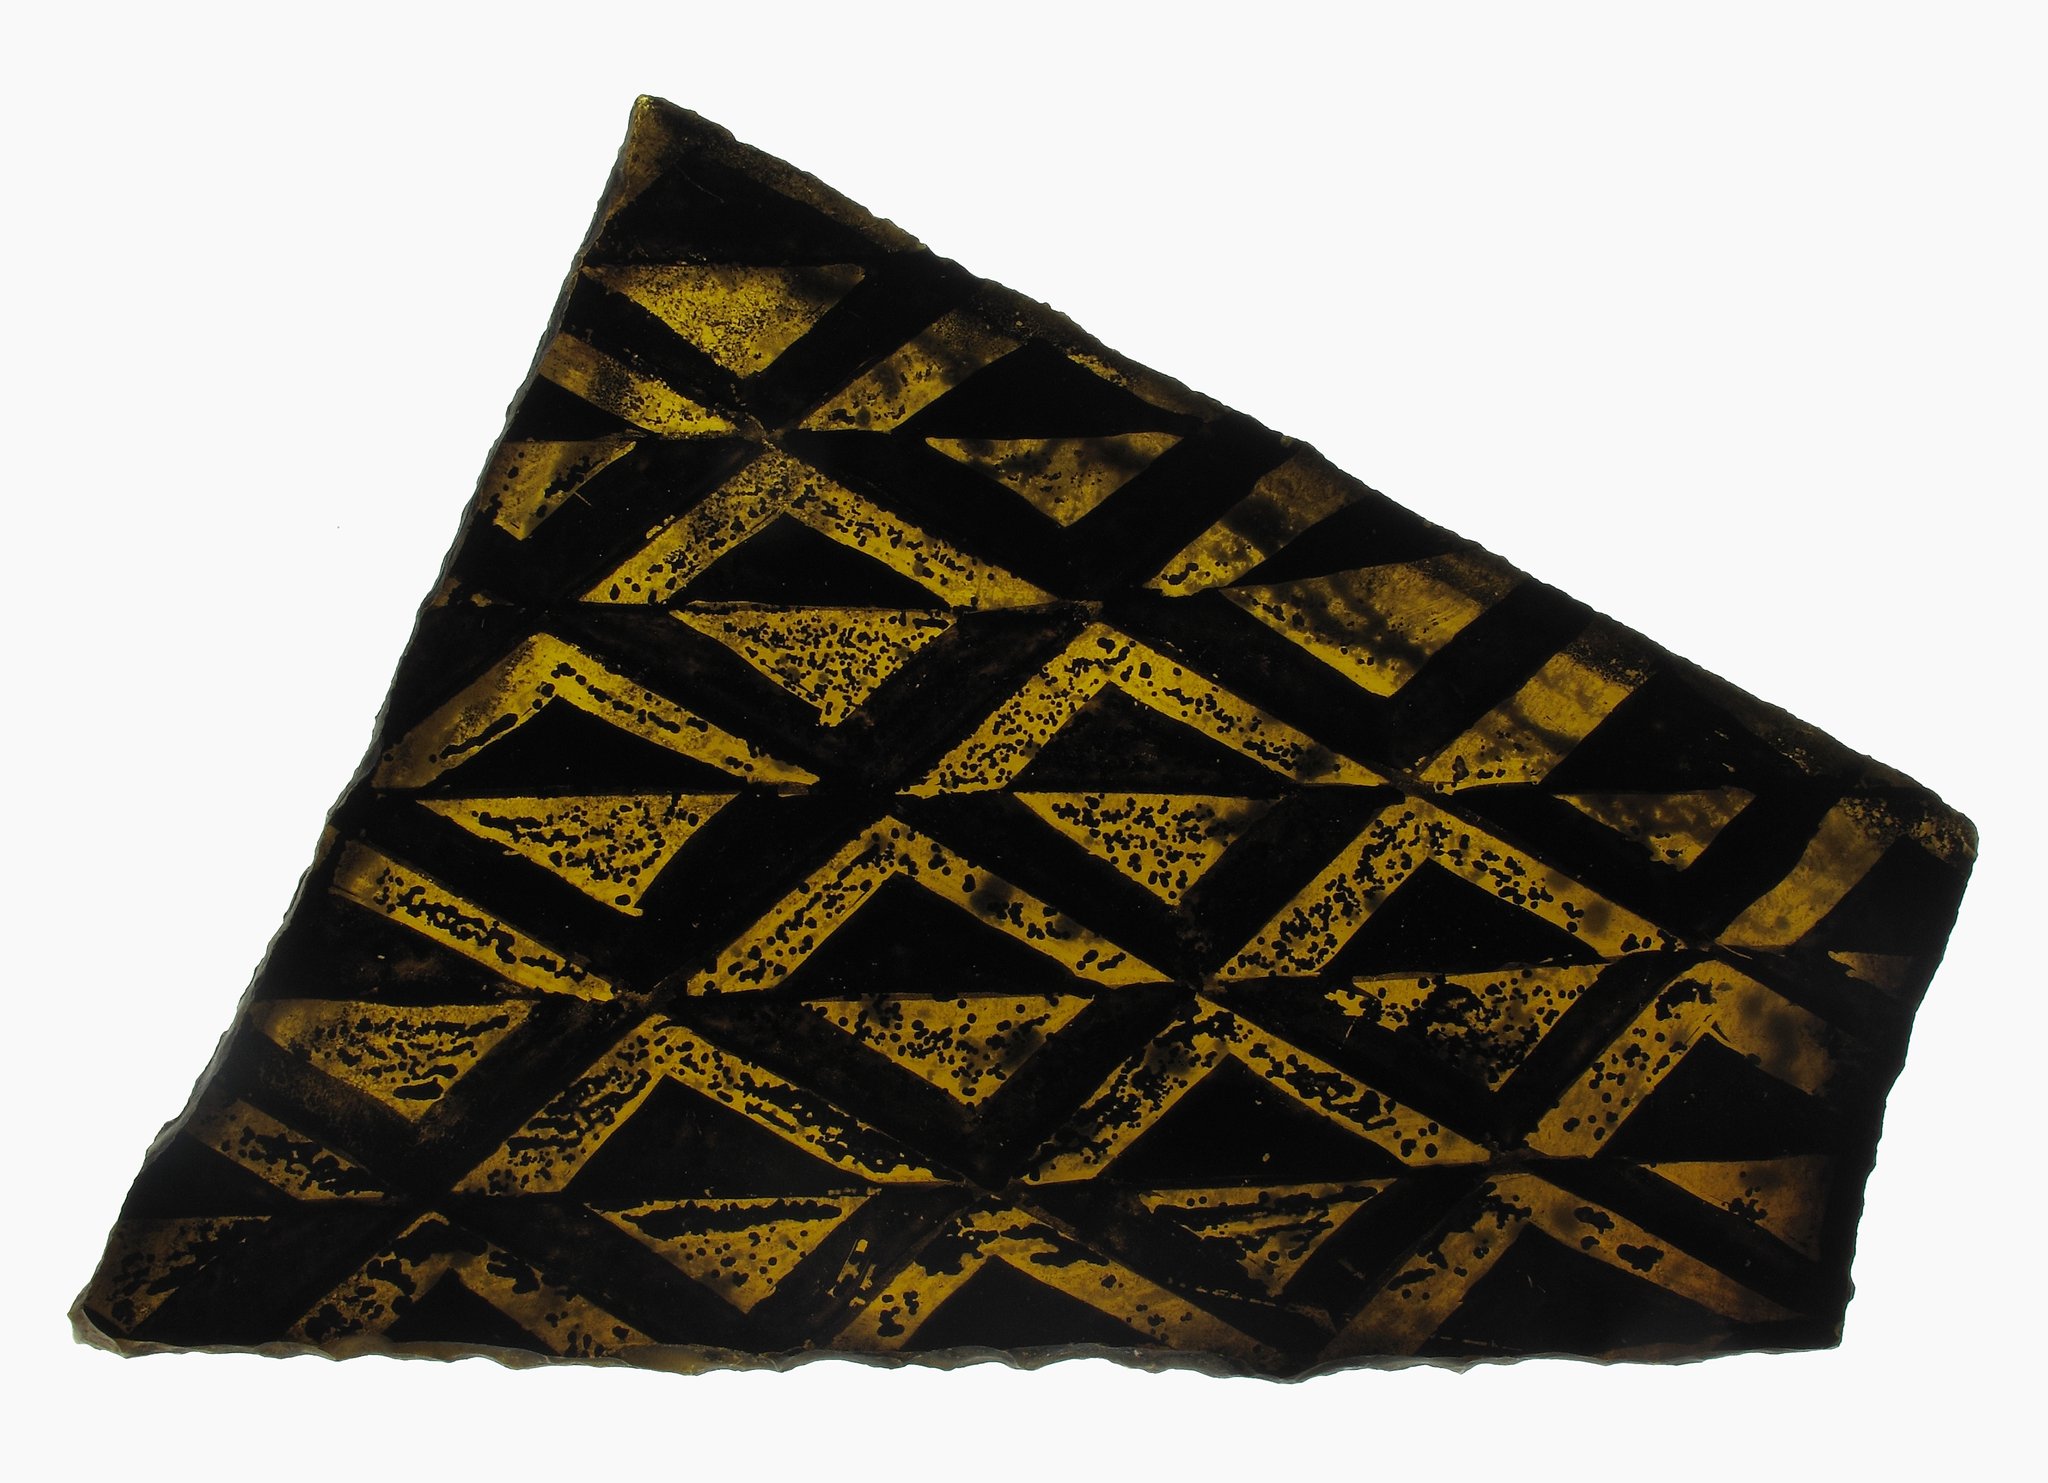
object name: fragment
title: Glass Fragment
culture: european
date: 1301-1500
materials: glass, metal